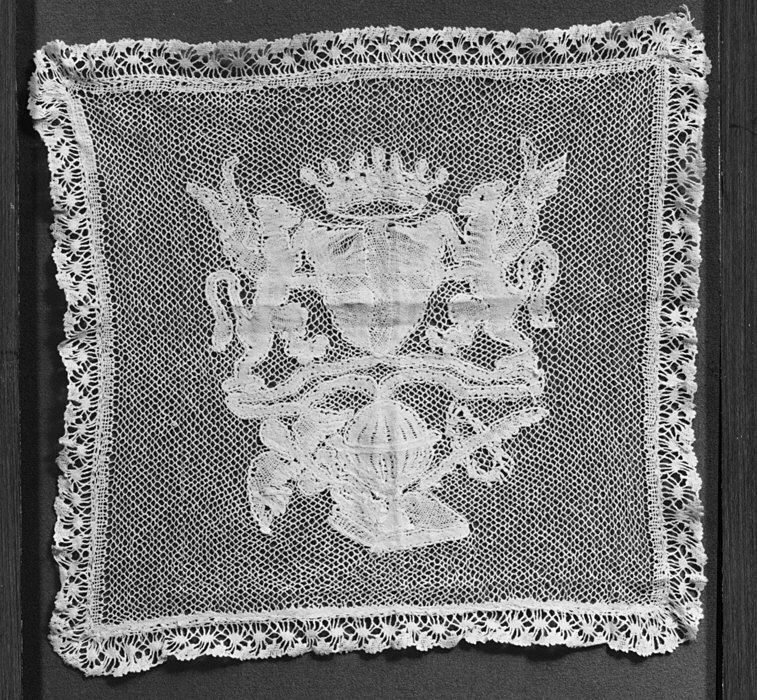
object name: cover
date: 1701-1800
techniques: lace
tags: coat of arms